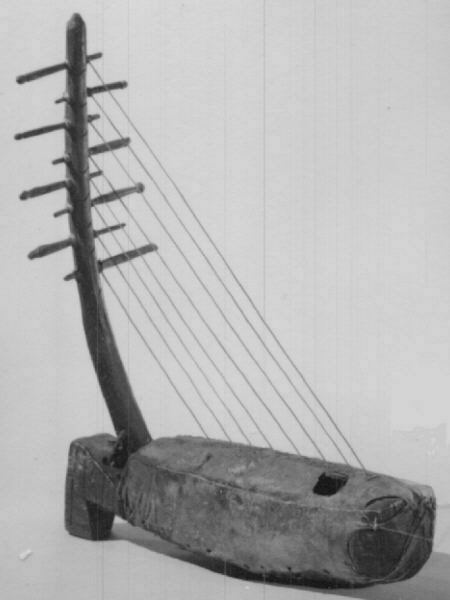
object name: ombi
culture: fang or pahuin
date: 1867-1900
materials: wood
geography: gabon